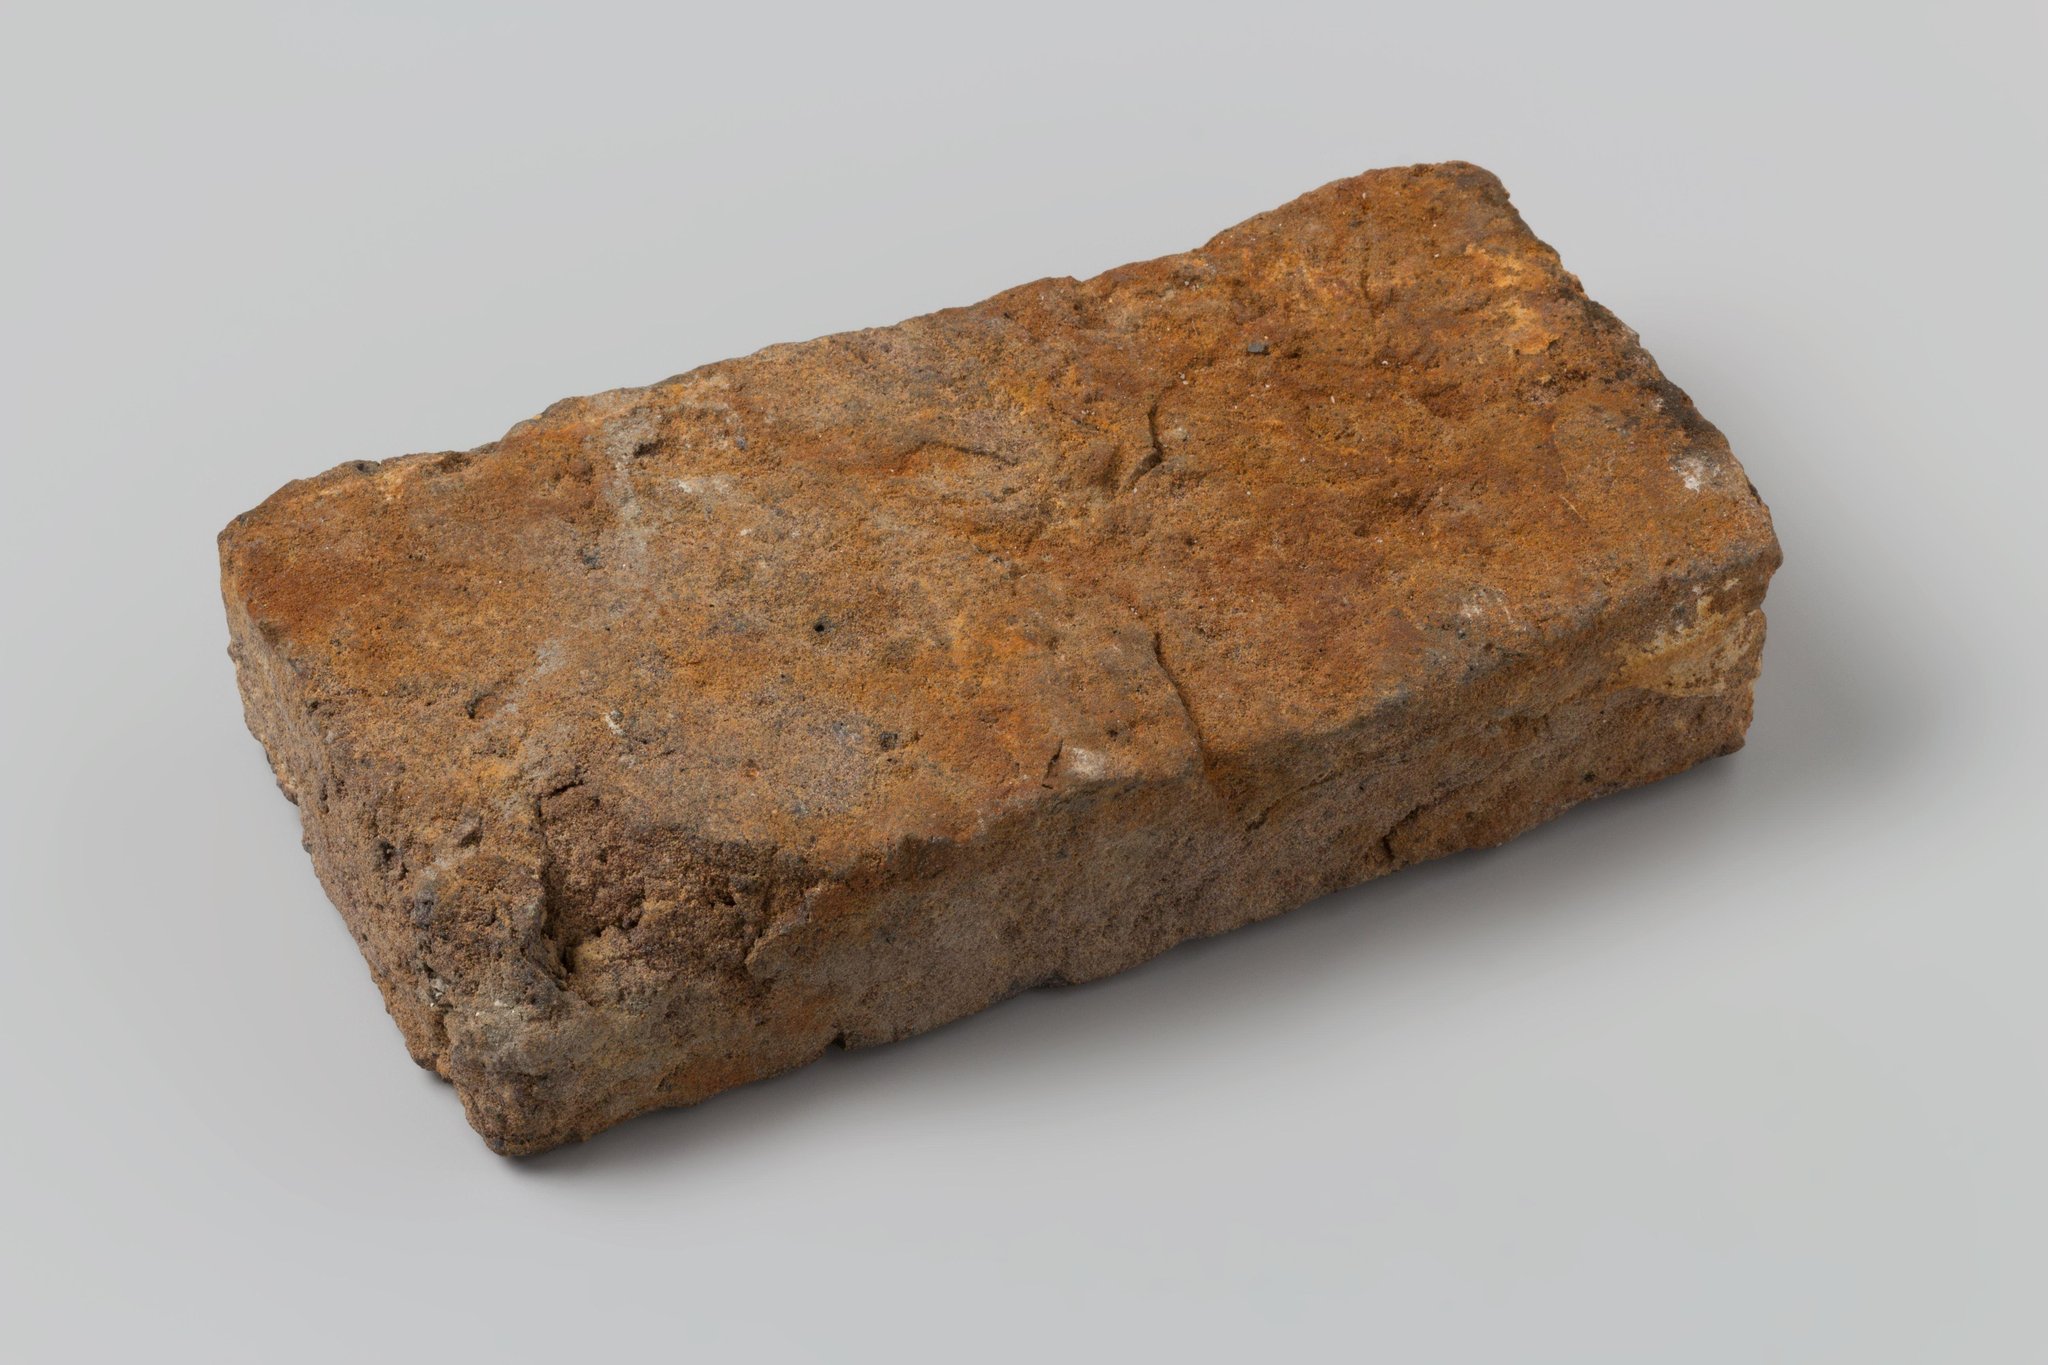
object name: brick clay product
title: Baksteen uit het wrak van de Oost-Indiëvaarder Hollandia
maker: Anonymous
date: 1700-1743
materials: brick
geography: netherlands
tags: verenigde oostindische compagnie, hollandia (schip), annet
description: Constructional elements, brick; rectangular.